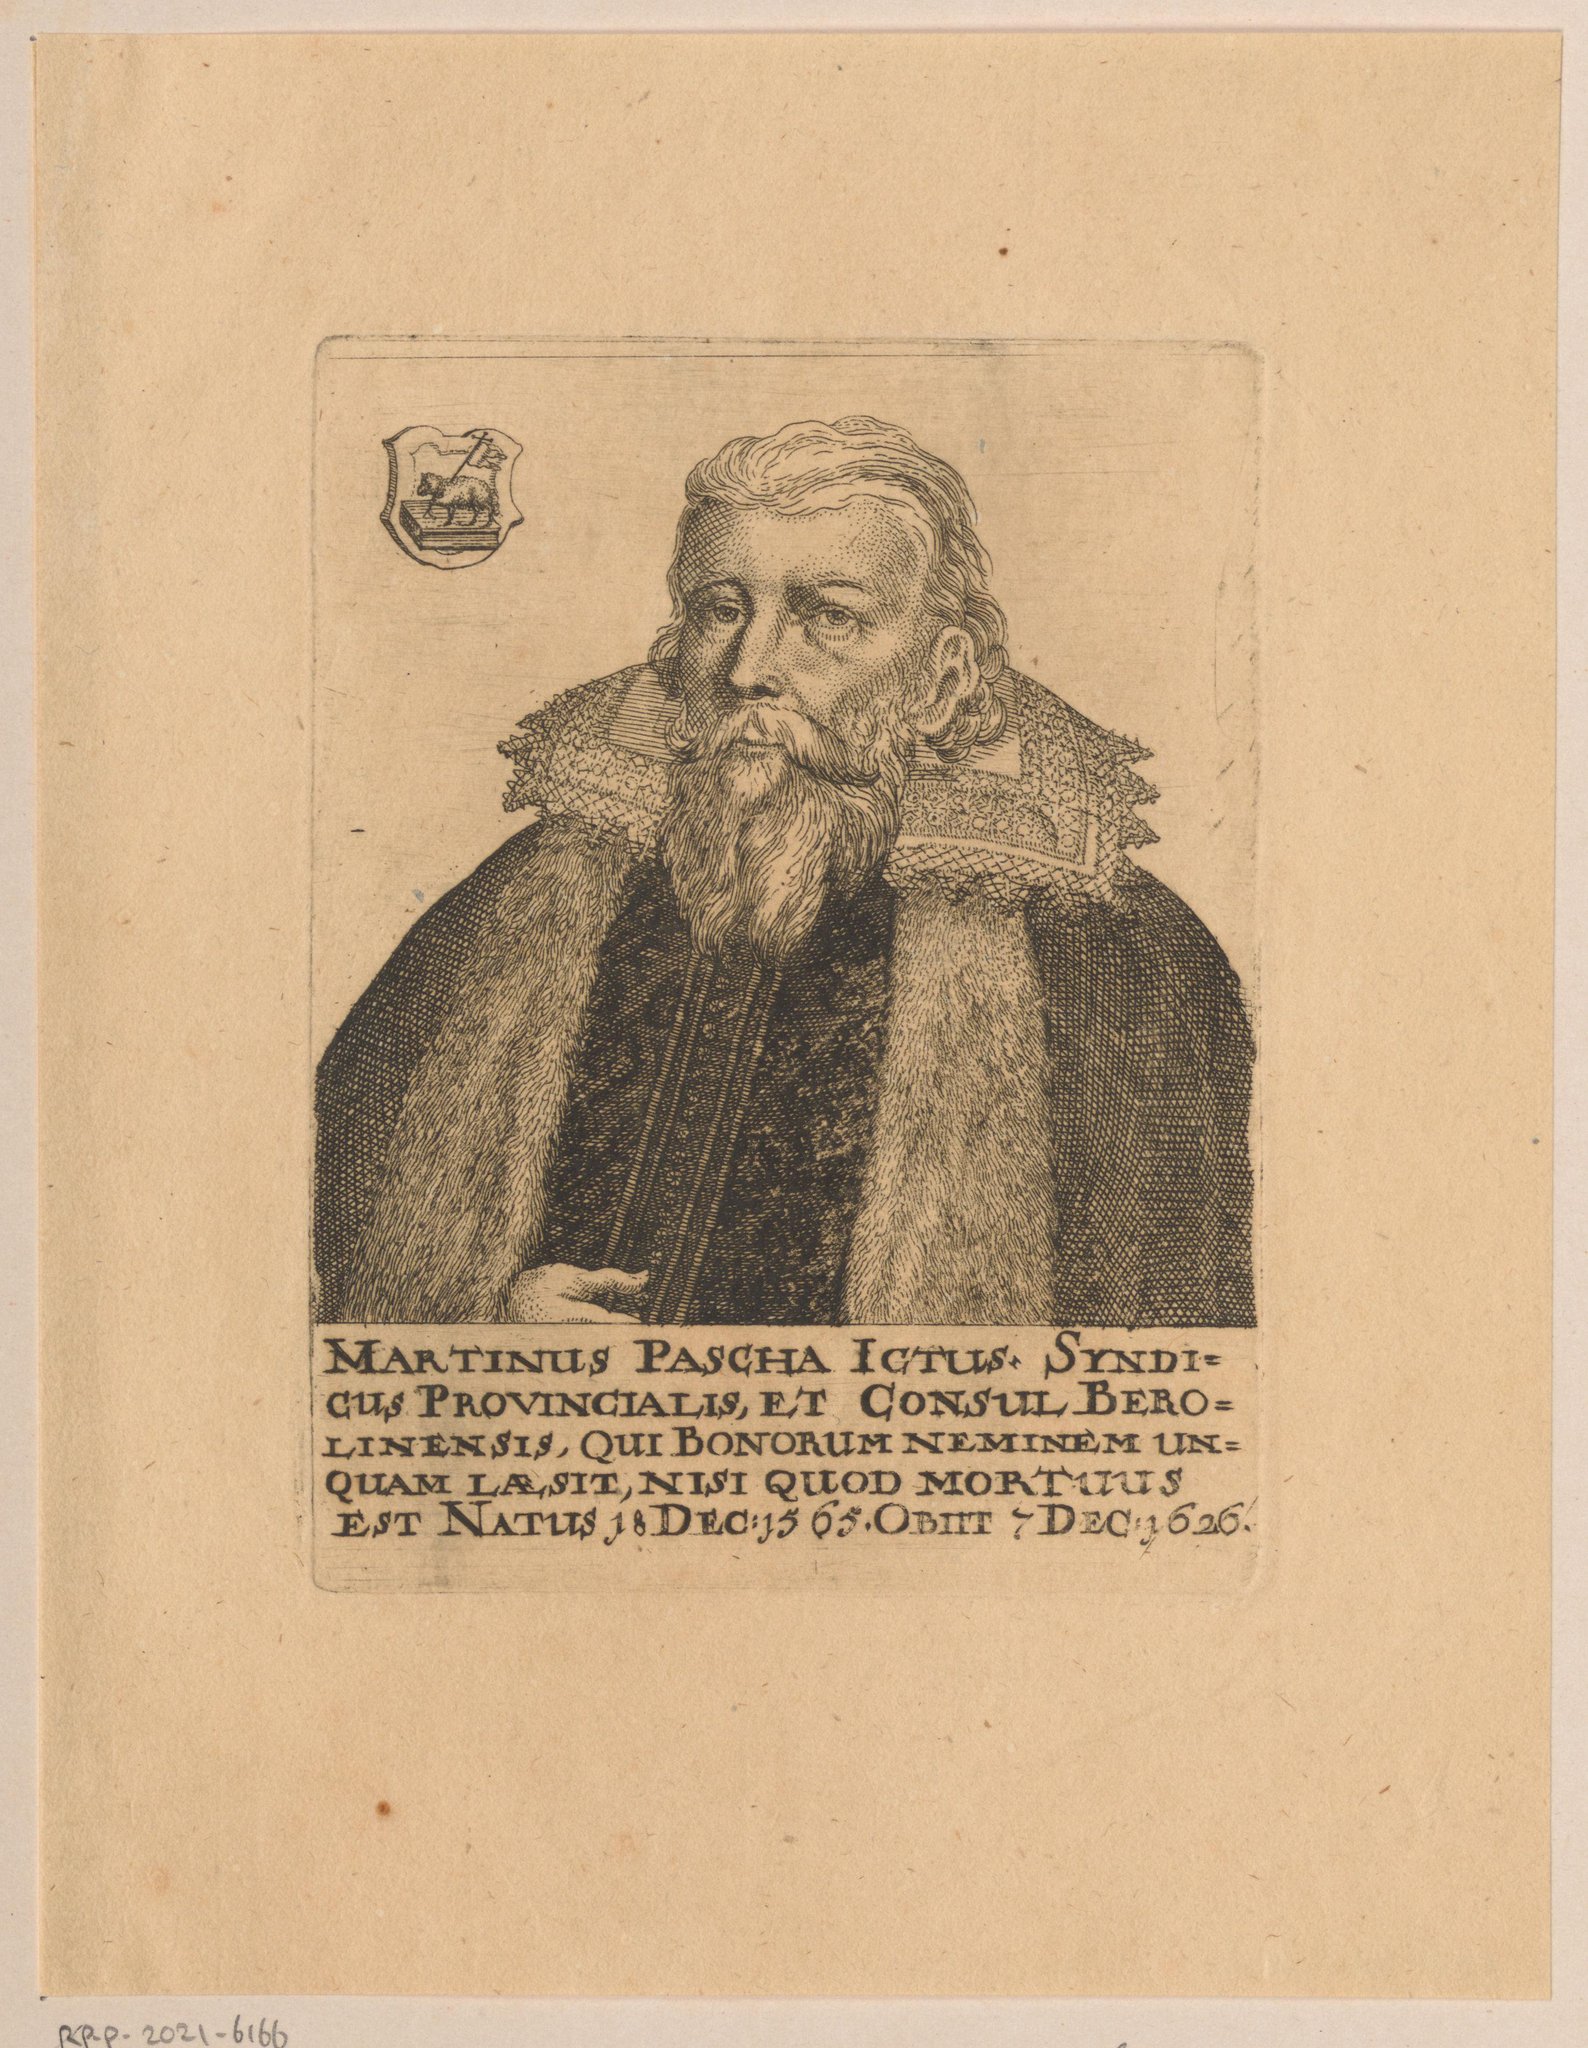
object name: print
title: Portret van Martin Pasche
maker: Anonymous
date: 1671-1751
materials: paper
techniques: engraving, etching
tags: adult man, historical persons, armorial bearing, heraldry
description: Een andere staat van deze prent is uitgegeven als onderdeel van een serie. Later is die prent mogelijk ook als boekillustratie gebruikt in: Küster, Georg Gottfried. Martin Friedrich Seidels Bilder-Sammlung in welcher hundert, gröstentheils in der Mark Brandenburg (…). Berlijn: Buchladen bey der Real-Schule, 1751. Het is onduidelijk of en tot welke uitgave de huidige prent behoort.